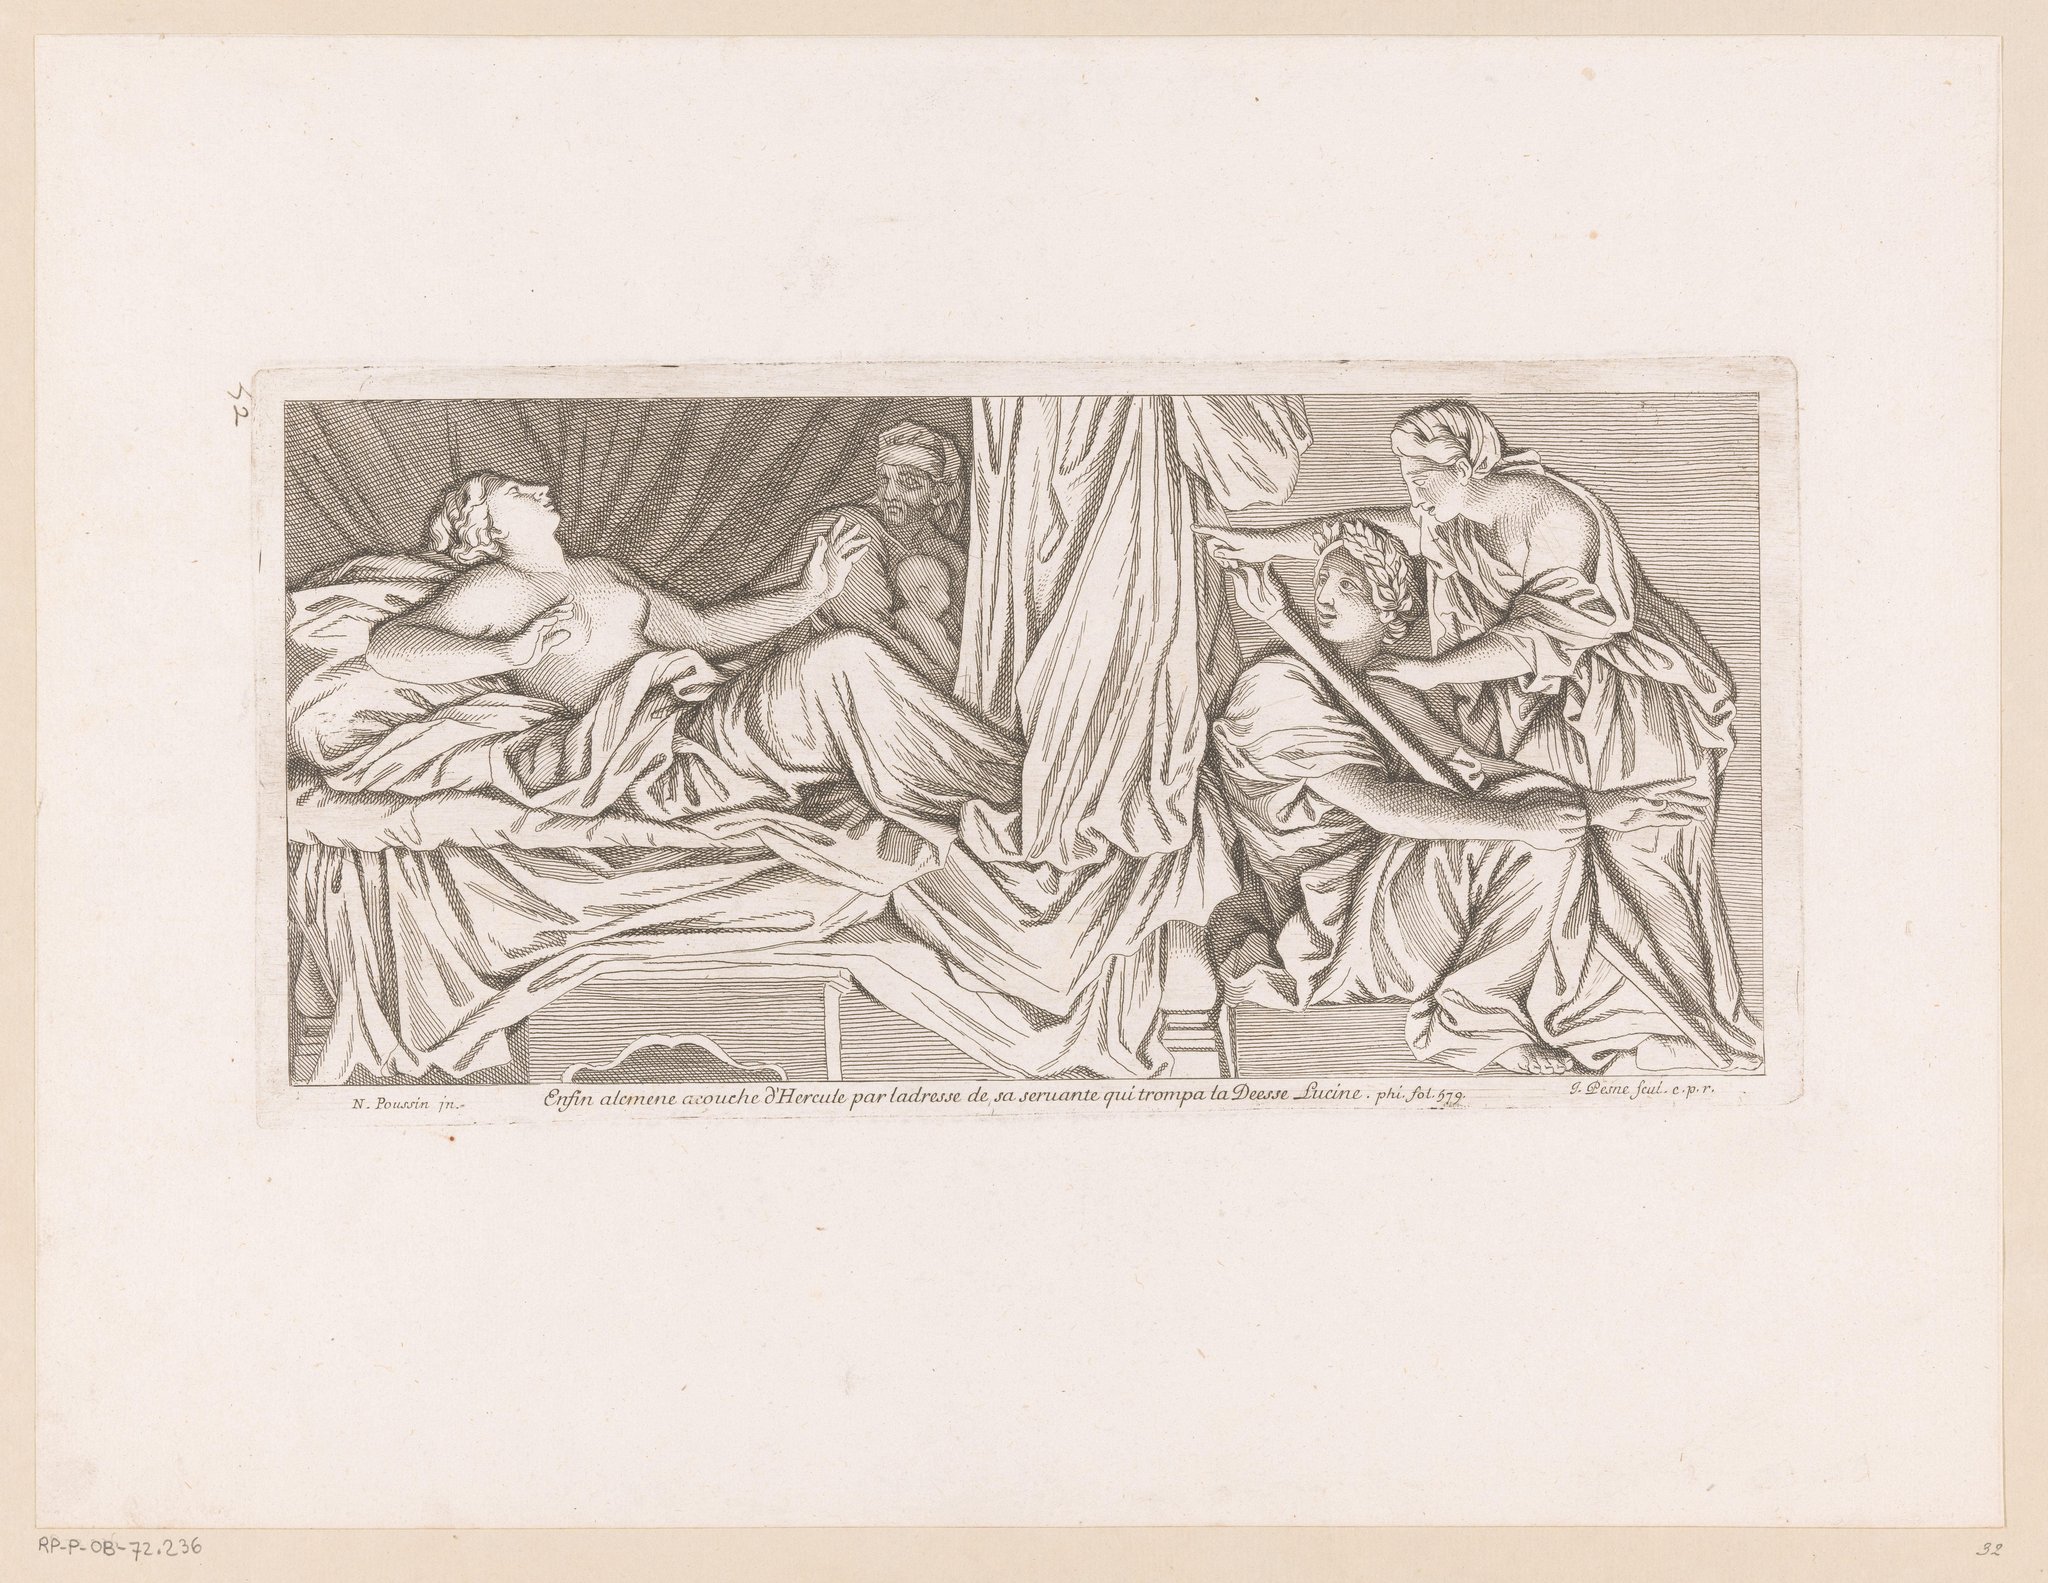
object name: print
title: Alkmene bevalt van Hercules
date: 1678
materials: paper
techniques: engraving, etching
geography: france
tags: birth of hercules and his twin brother iphicles; juno delays the birth by sitting outside alcmene's door with crossed knees and fingers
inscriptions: collector's mark: Lugt 240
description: Prent maakt deel uit van een ongenummerde serie van negentien prenten.